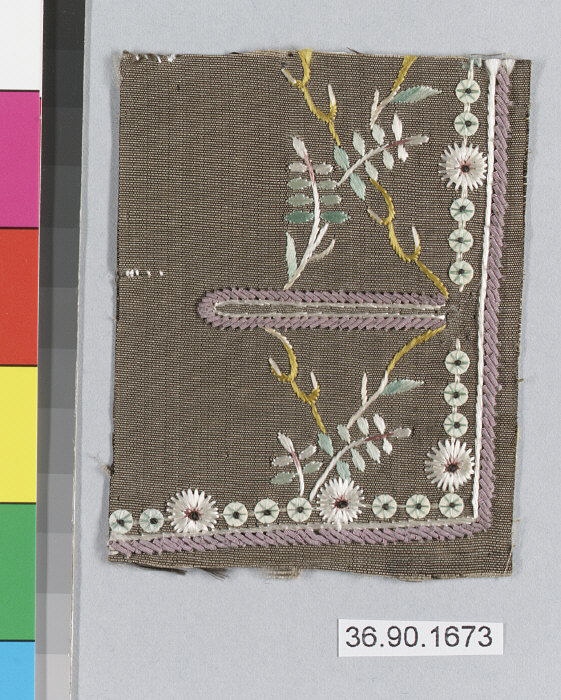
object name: sample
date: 1801-1833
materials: silk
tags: flowers